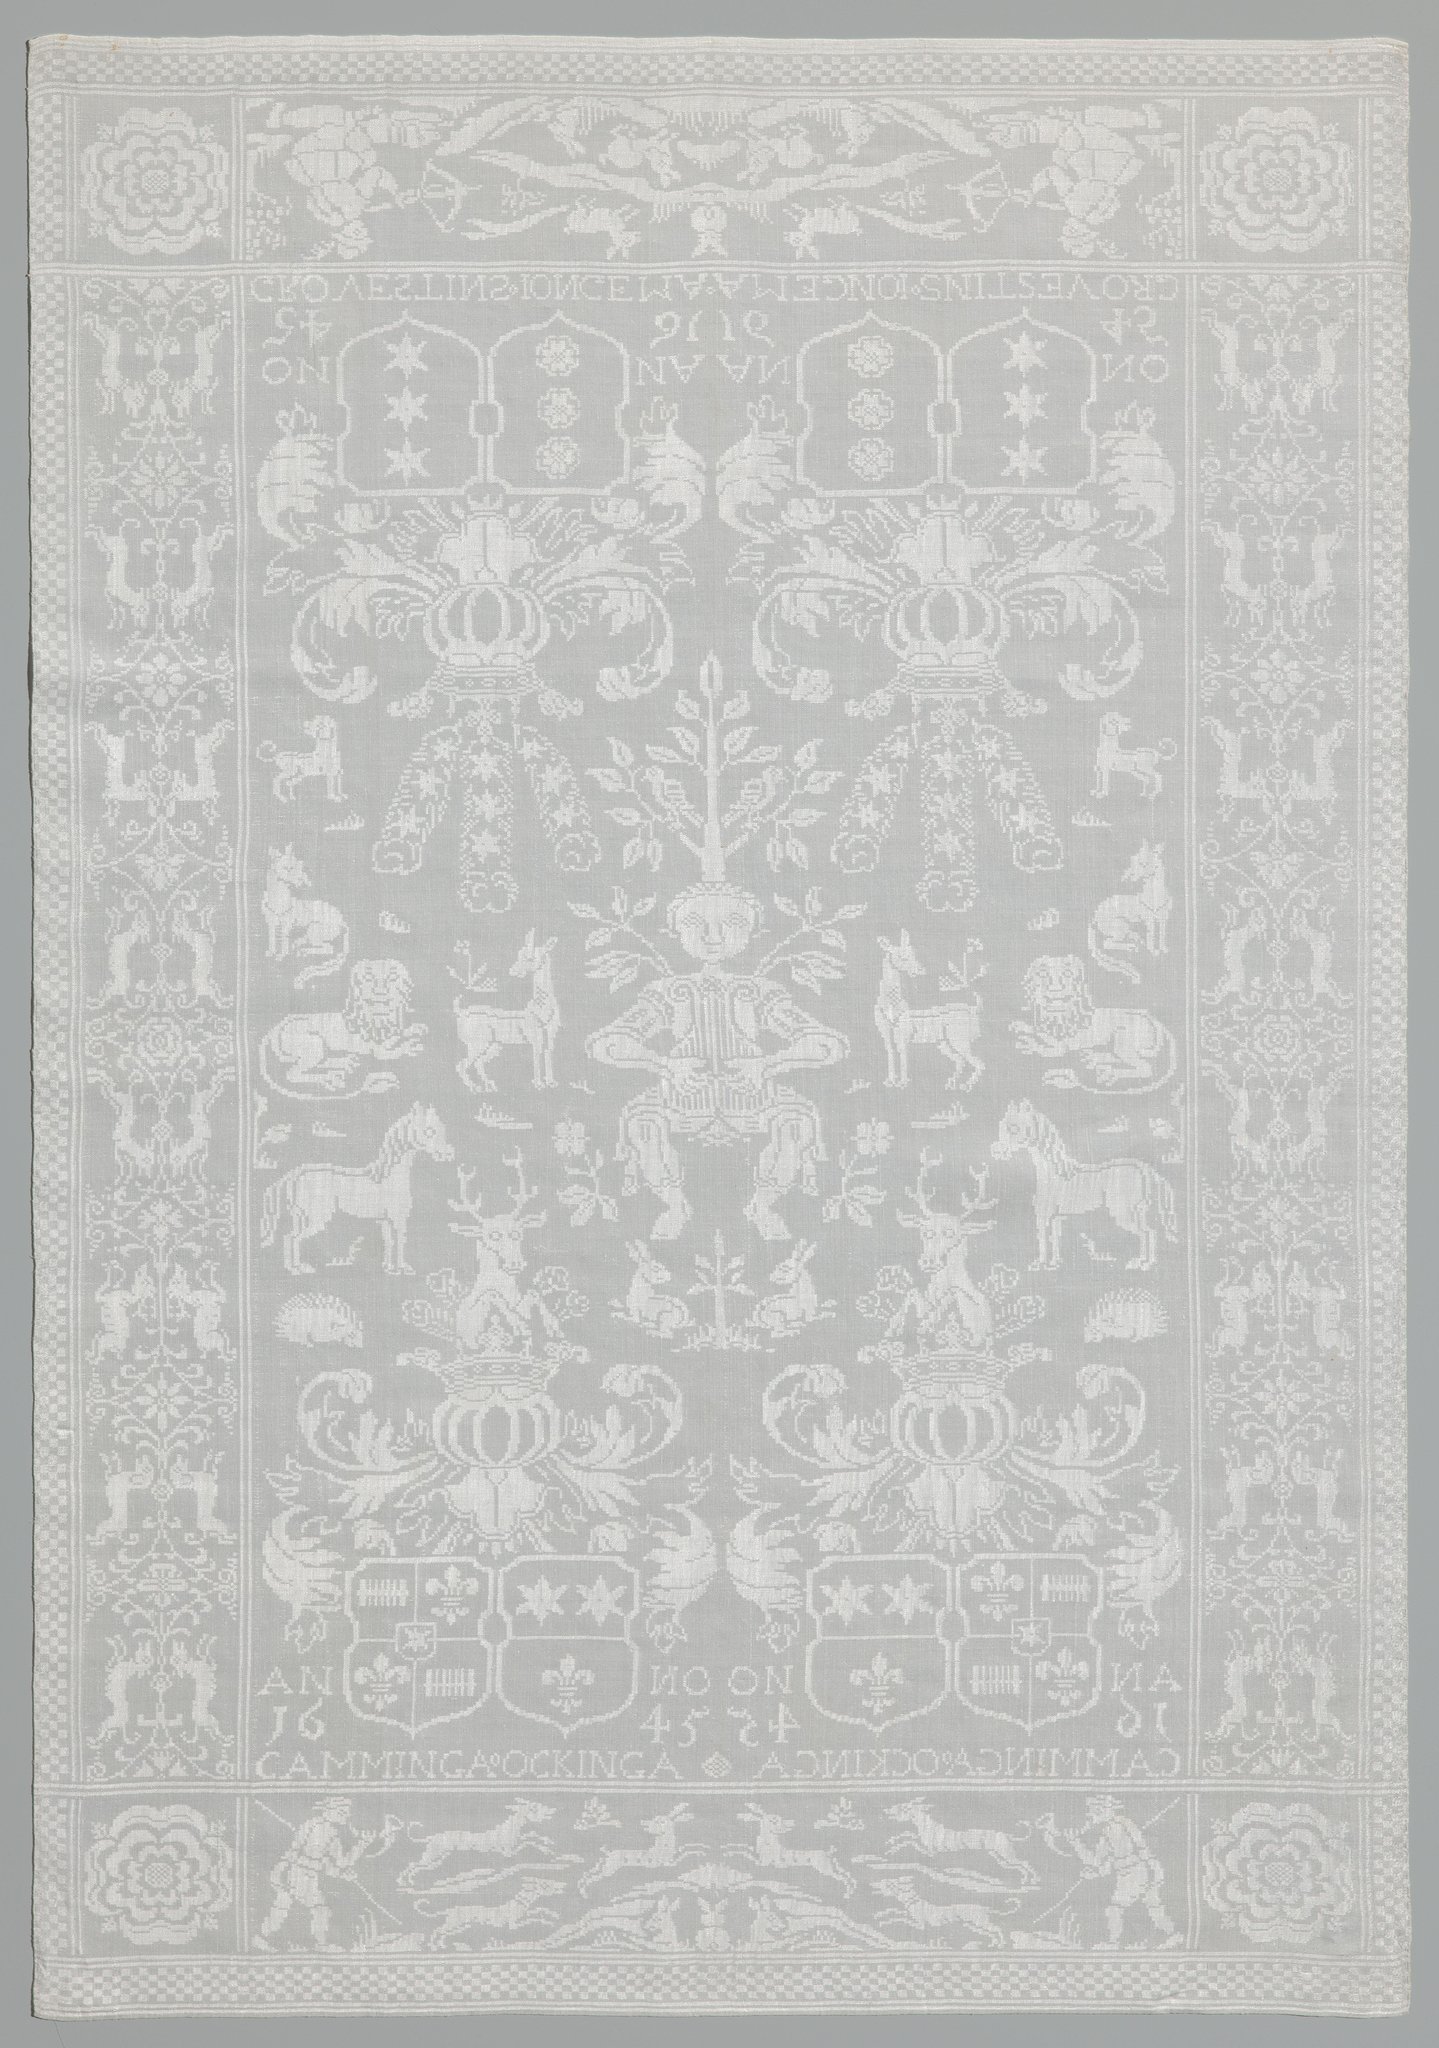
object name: napkin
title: Servet met Friese wapens en Orpheus te midden van de dieren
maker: quirijn jansz. damast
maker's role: mayor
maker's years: 1580-1638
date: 1645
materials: linen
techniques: damask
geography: haarlem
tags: orpheus playing the lyre: trees and rocks move, beasts and birds are enchanted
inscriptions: date